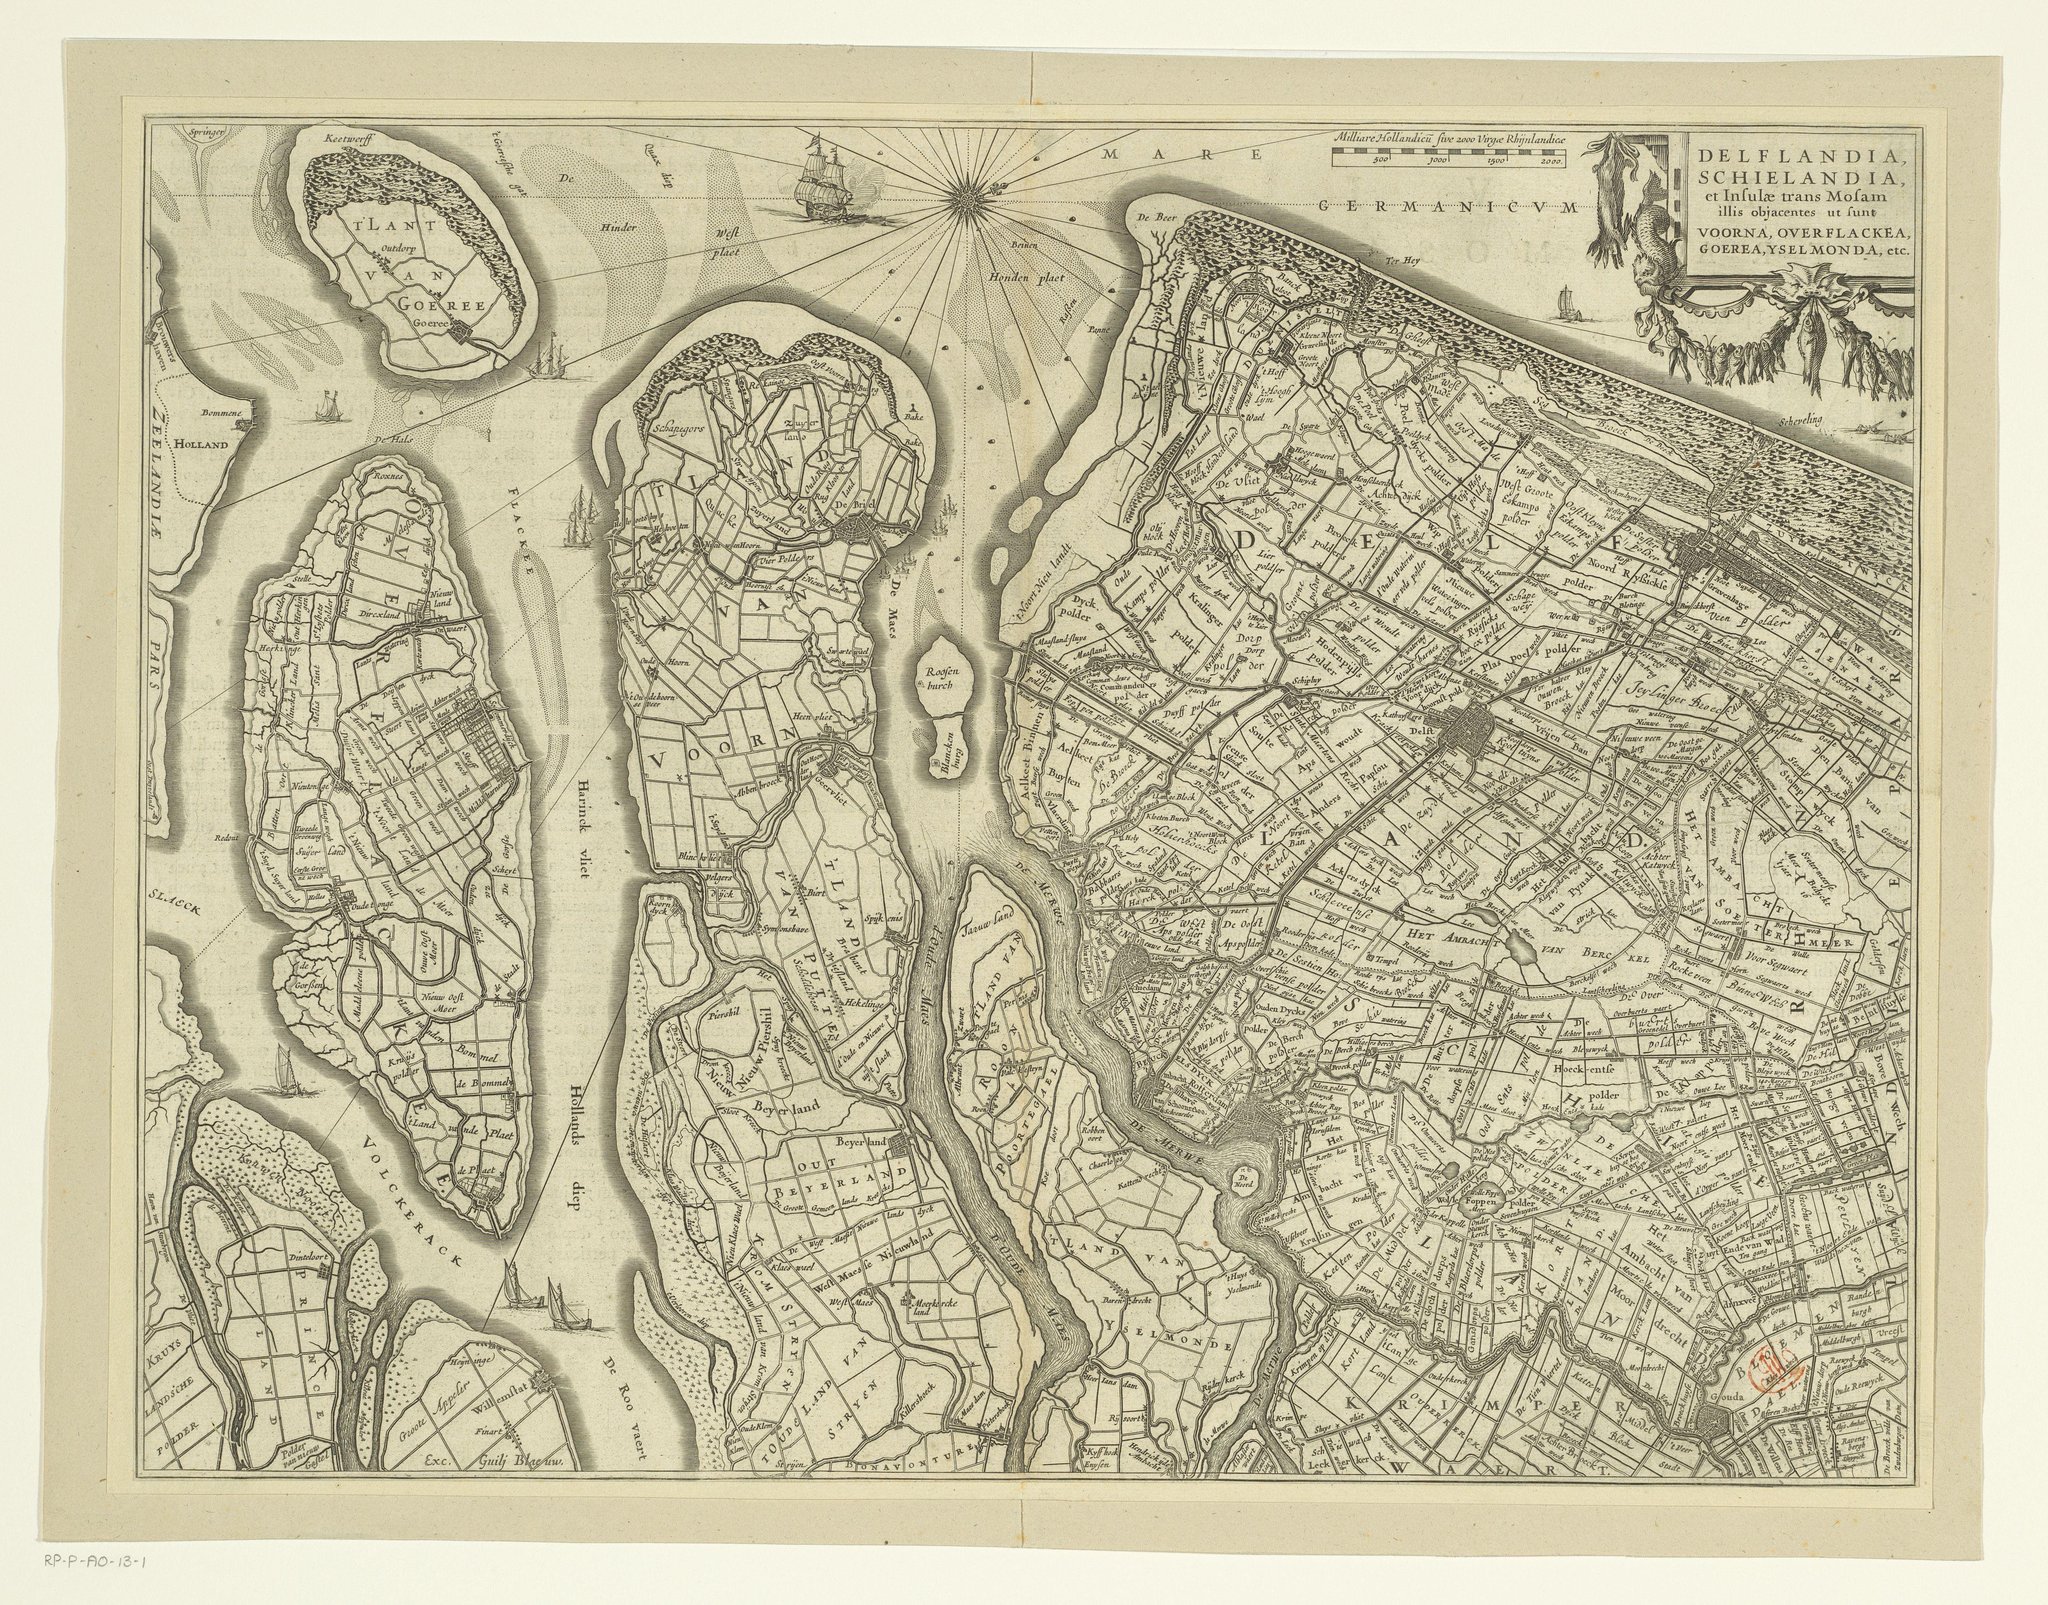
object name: print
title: Delflandia, Schielandia et insulae trans Mosam illis objacentes ut sunt Voorna, Overflackea, Goera, Yselmonda etc.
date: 1631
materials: paper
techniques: engraving, etching, letterpress printing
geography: amsterdam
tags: maps of separate countries or regions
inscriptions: collector's mark: Lugt 2228, collector's mark: Lugt 195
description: Kaart van Delfland, Schieland en de Zuid-Hollandse eilanden (onder andere Voorne, Overflakkee, Goeree en IJsselmonde). Rechtsboven de titelcartouche. Links daarvan een schaalstok: Milliare Hollandicu[m] sive 2000 virgae Rhijnlandicae. Oriëntatie: noorden rechts. Op verso Latijnse tekst.